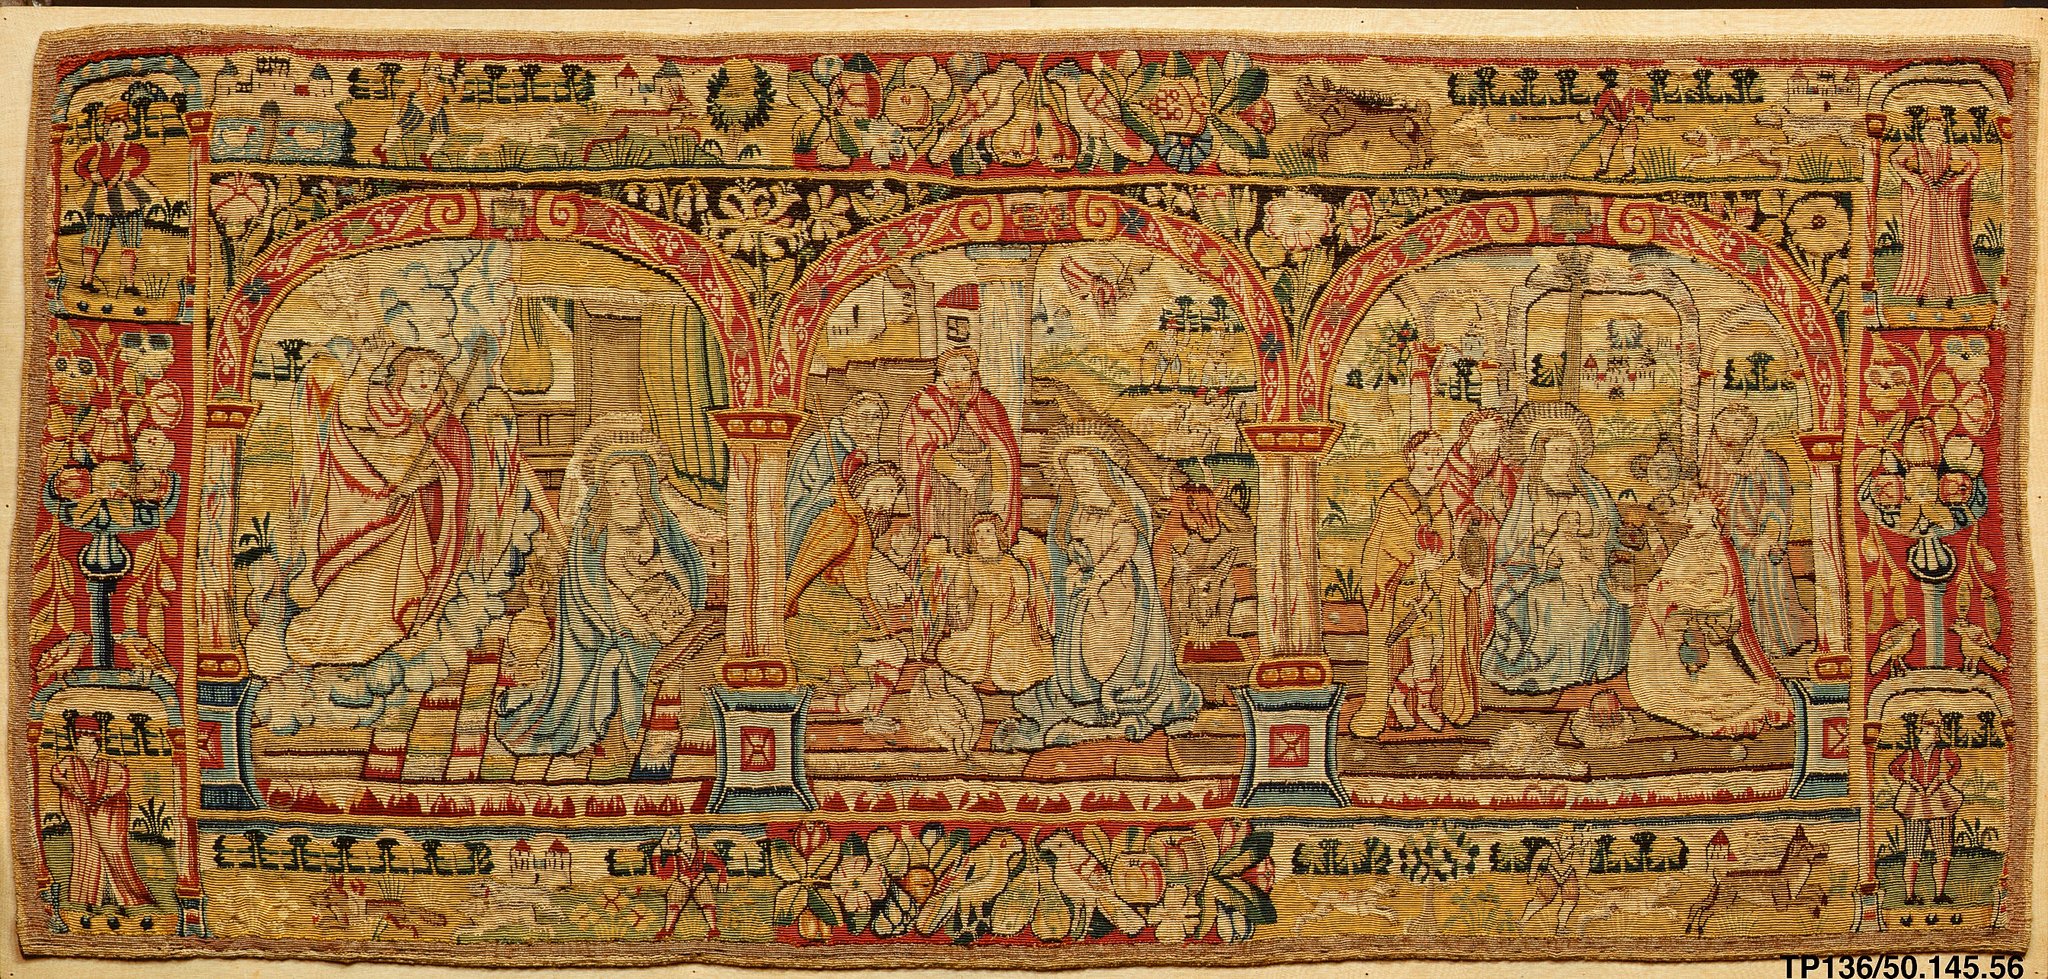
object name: cushion cover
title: The Annunciation, Adoration of the Shepherds, and Adoration of the Kings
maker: anonymous workshop, british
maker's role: artist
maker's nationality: british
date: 1601-1633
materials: silk, silver gilt, thread, wool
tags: animals,men,women,annunciation